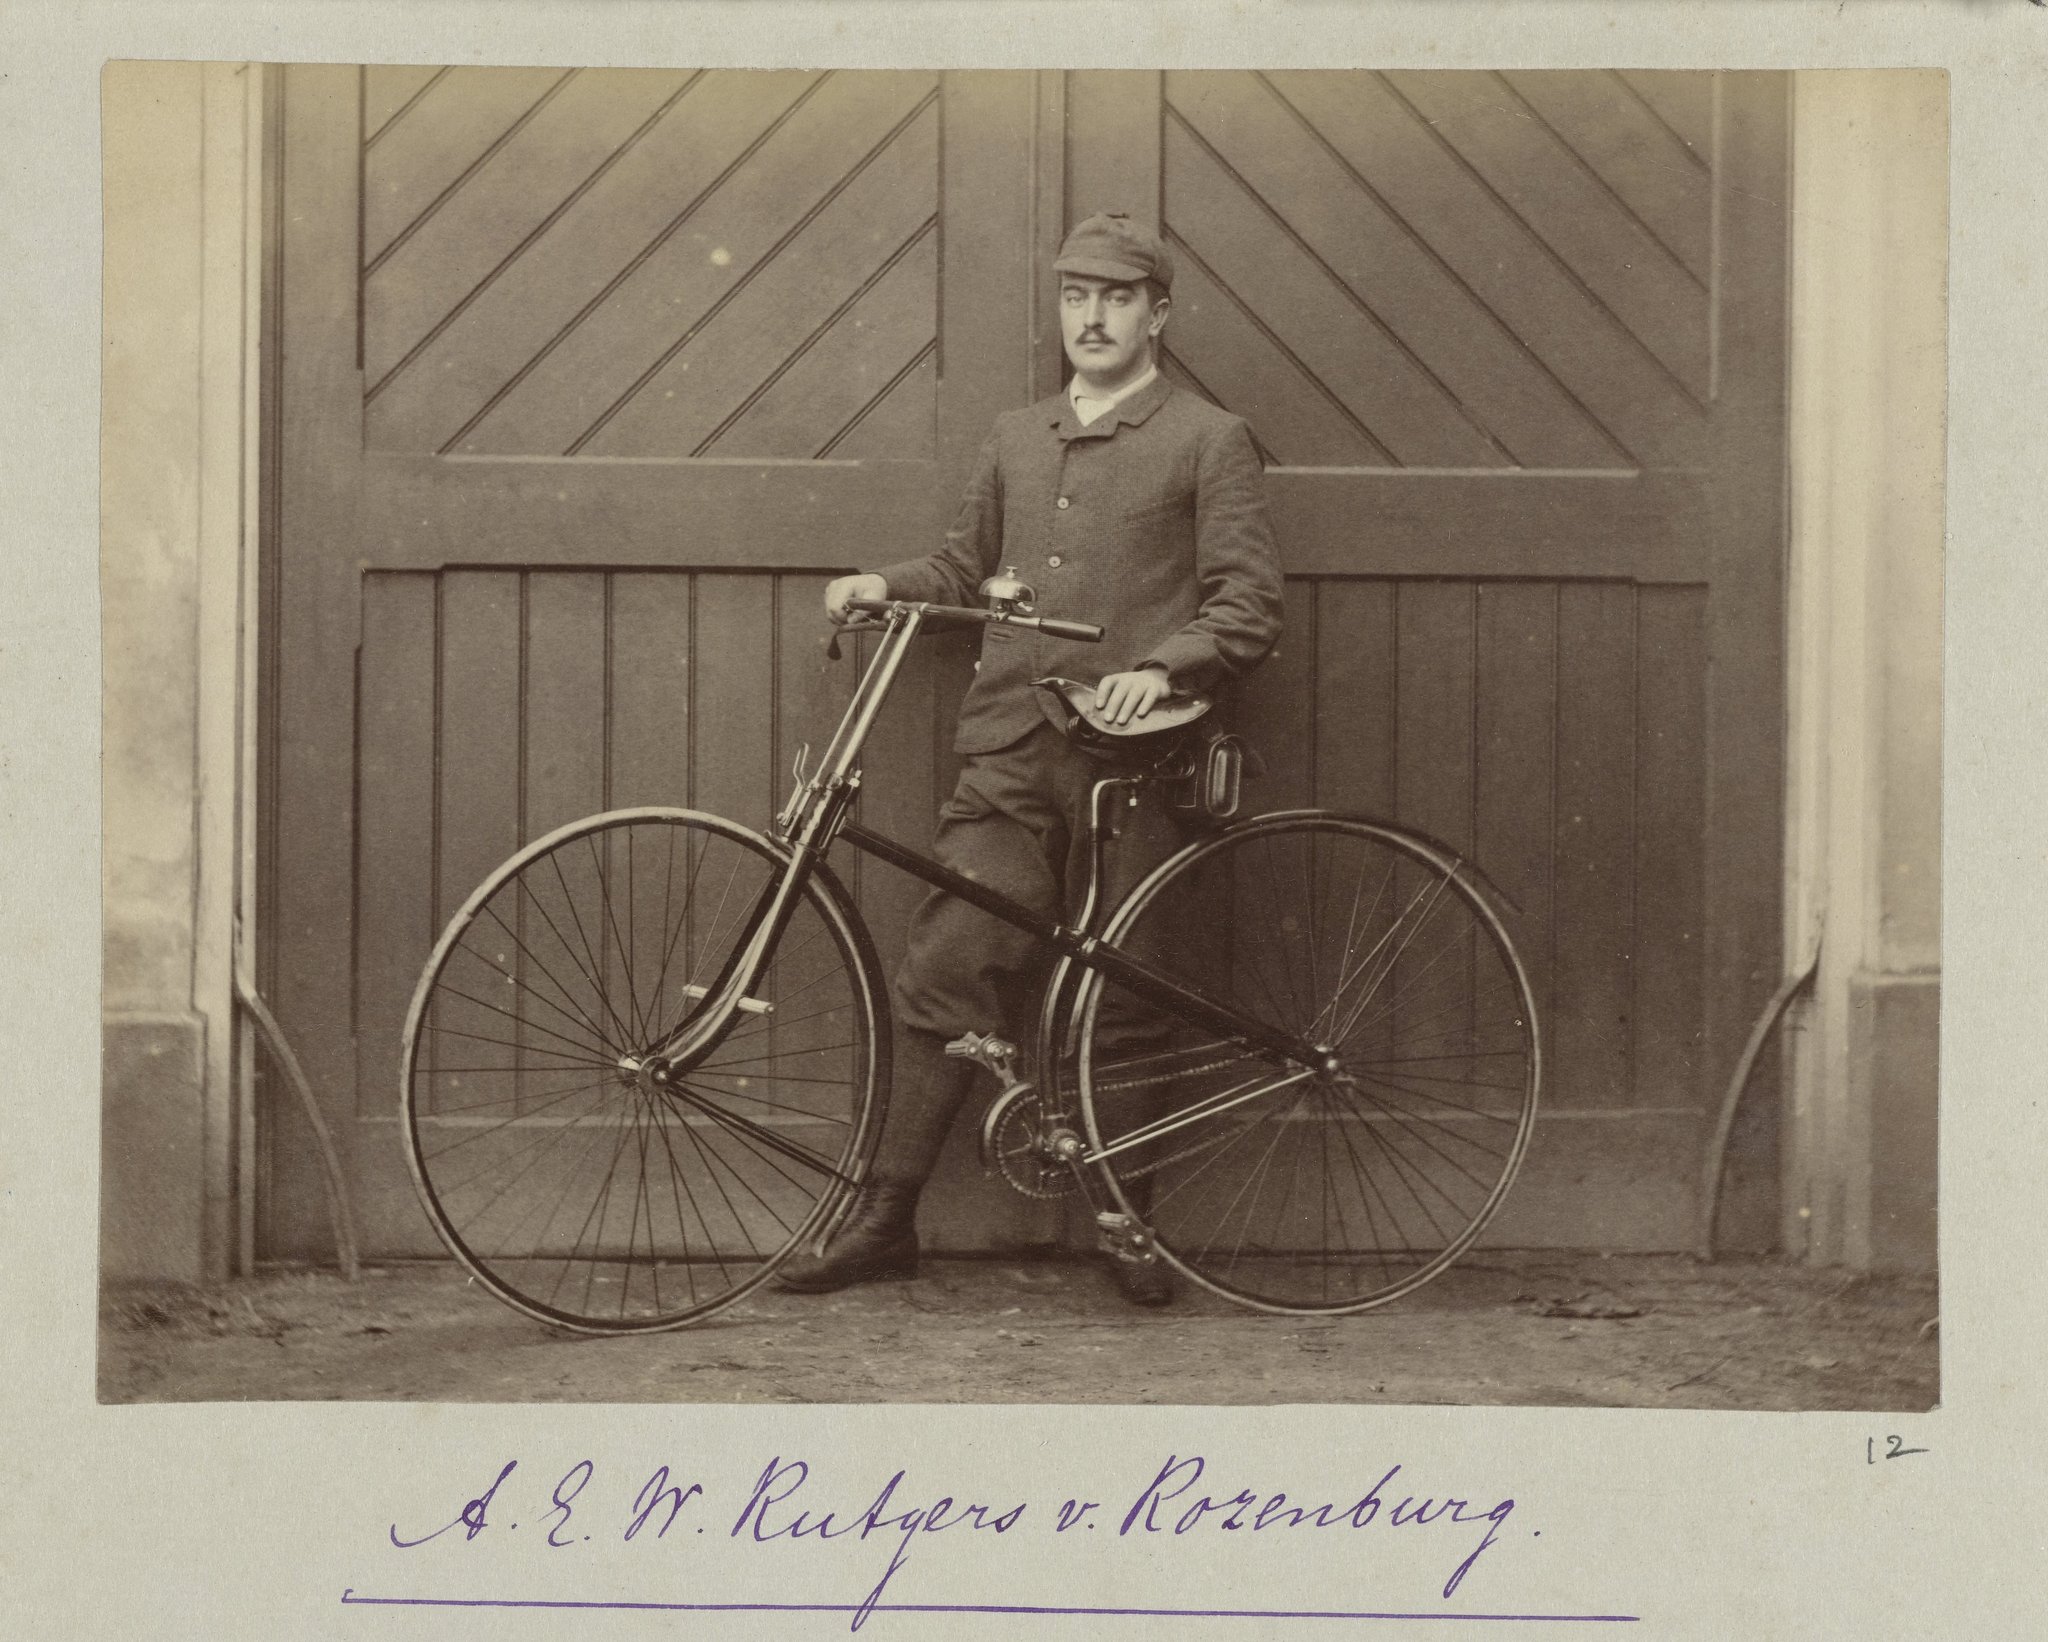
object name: photograph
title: Portret van de heer A.E.W. Rutgers van Rozenburg met een fiets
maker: henry pauw van wieldrecht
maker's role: fotograaf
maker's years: 1863-1912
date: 1888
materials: paper, photographic support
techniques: albumen print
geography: netherlands